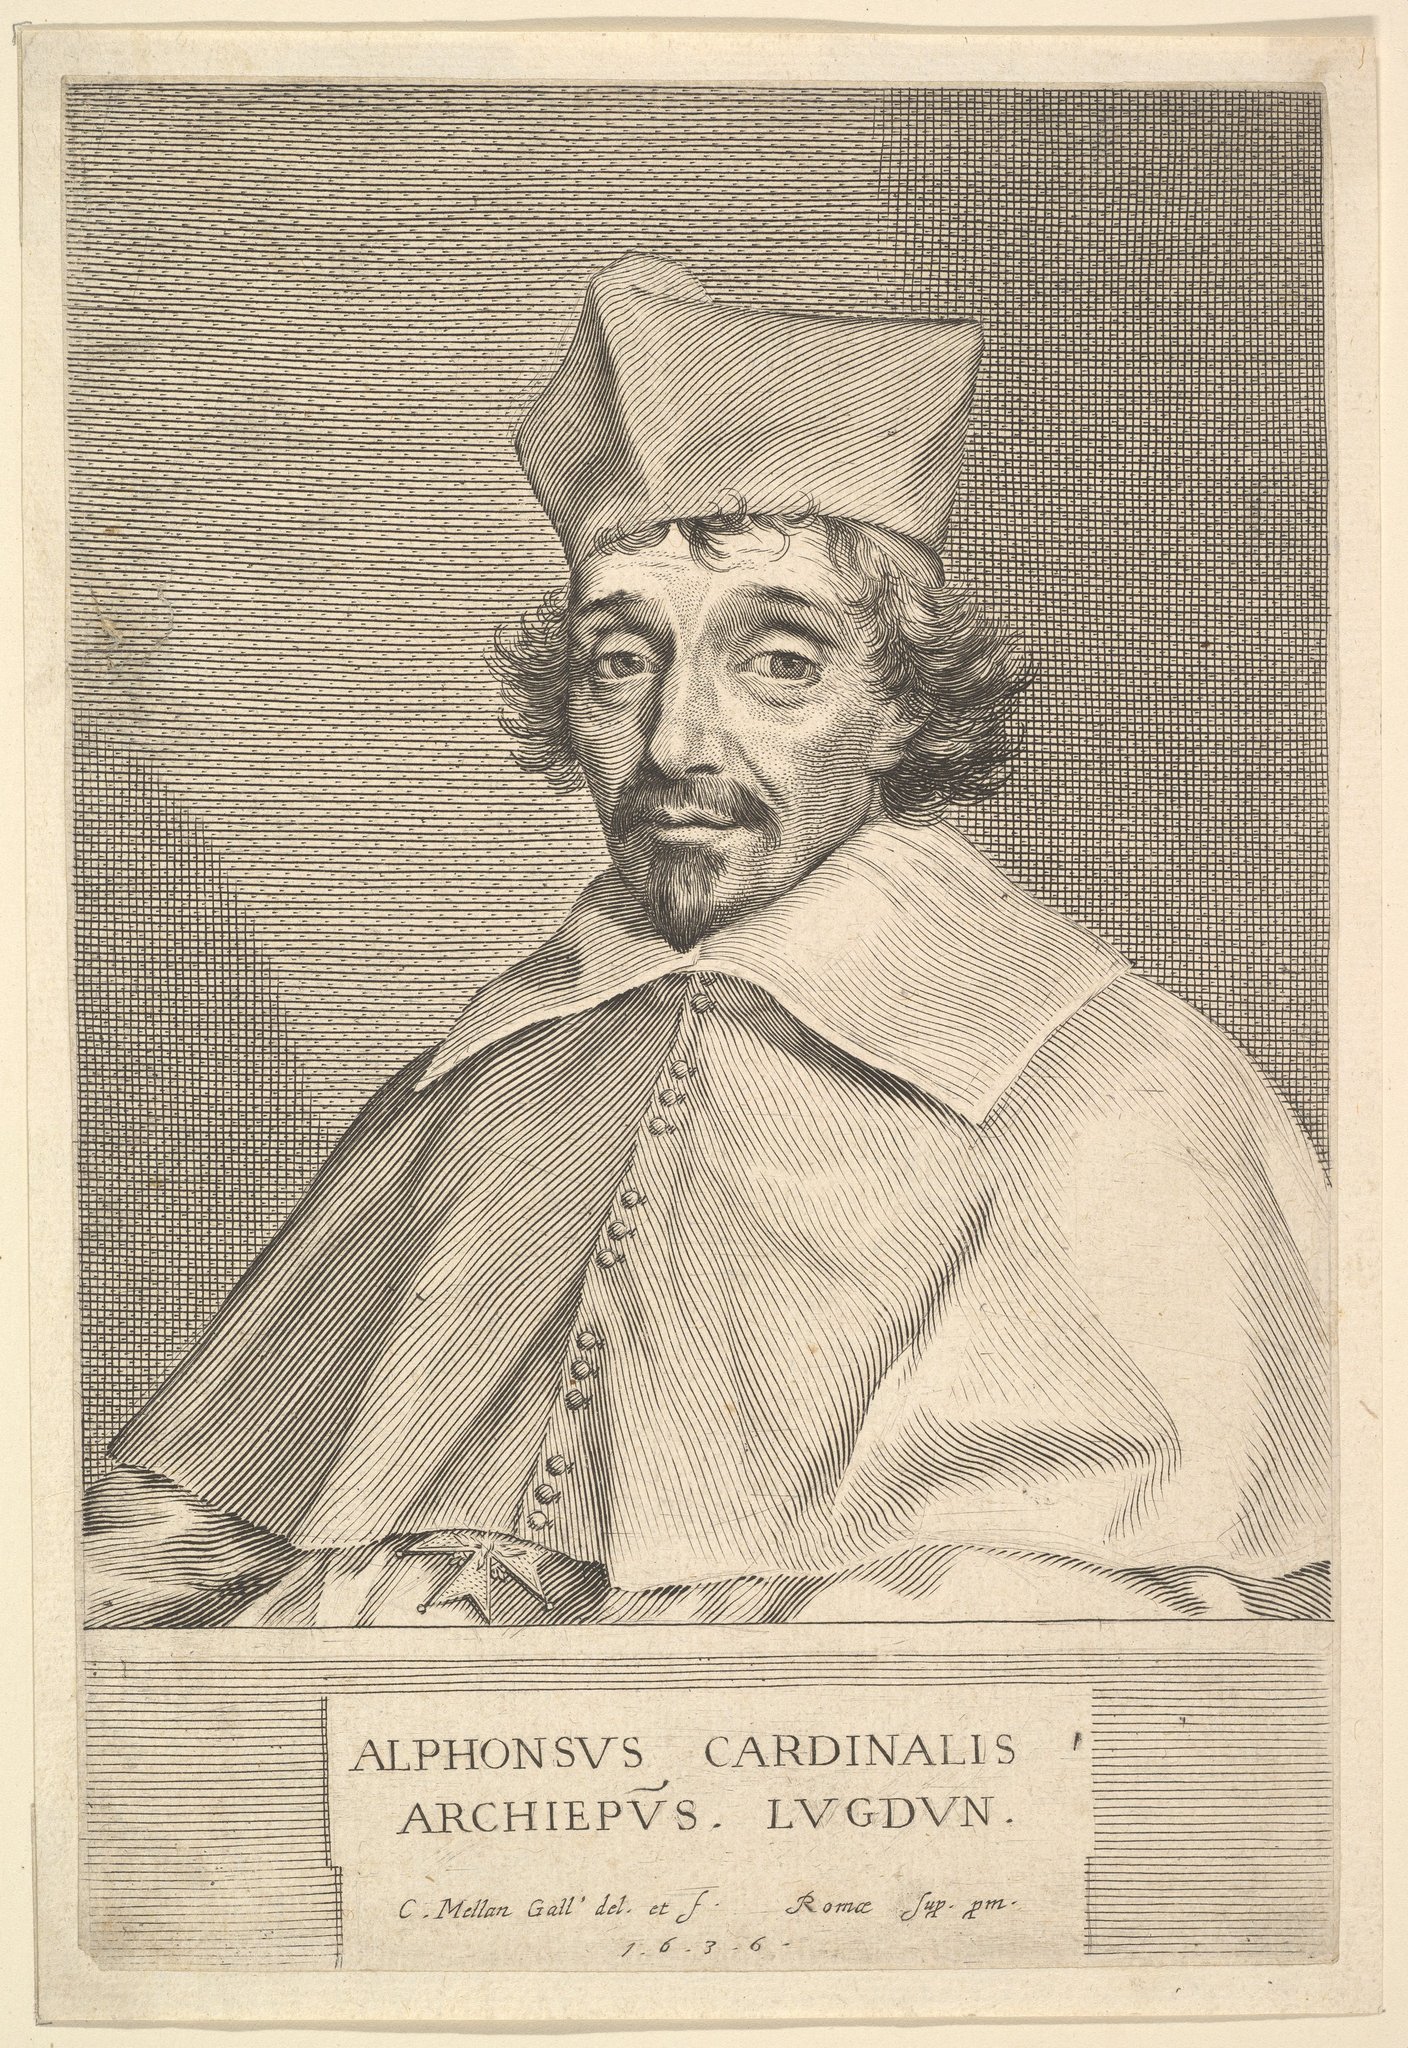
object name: print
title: Alphonse Du Plessis de Richelieu, cardinal de Lyon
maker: claude mellan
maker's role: artist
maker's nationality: french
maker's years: 1598-1688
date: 1636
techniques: engraving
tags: men,portraits